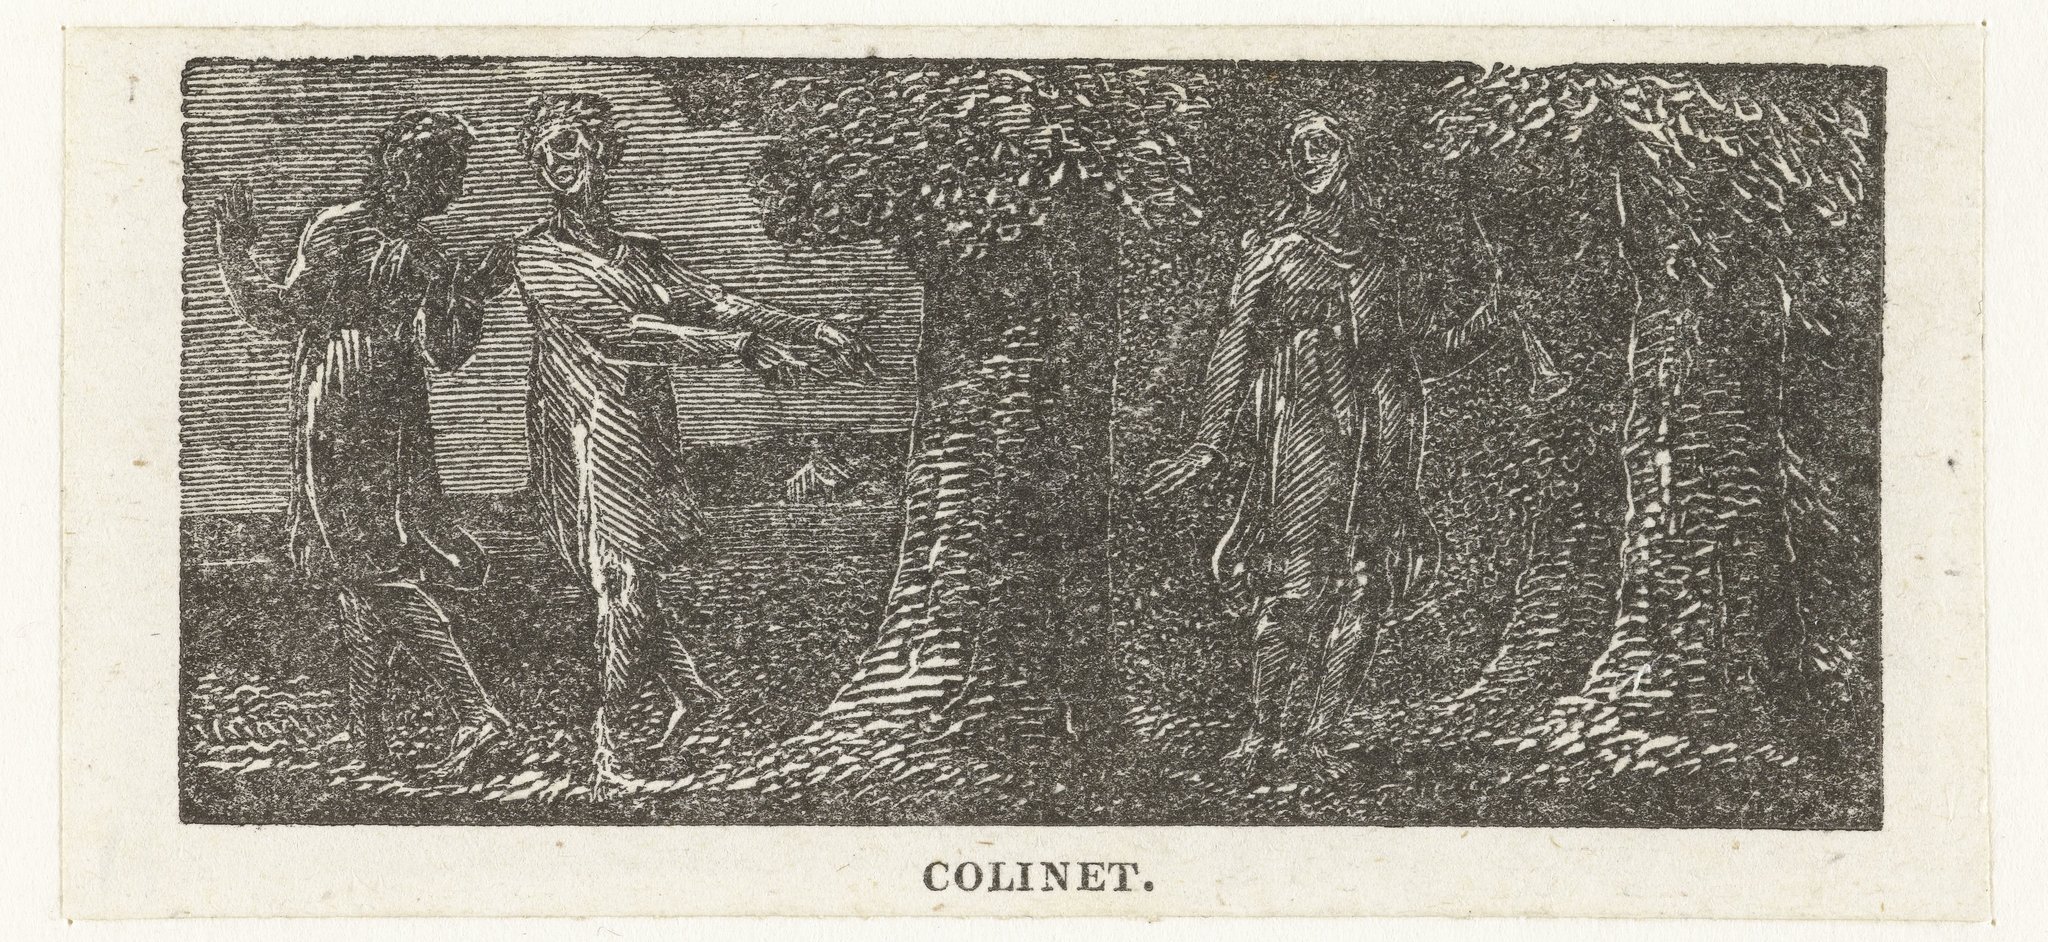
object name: print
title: Colinet mocked by two boys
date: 1820-1821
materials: paper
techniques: engraving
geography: england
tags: mocking, insulting; teasing, illustration ~ printed matter, book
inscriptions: collector's mark: Lugt 2228, inscription: ‘Colinet’, collector's mark: Lugt 2760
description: Illustratie uit "Imitations of Ecologue I", de achttiende-eeuwse imitatie van de eerste Ecloge van Vergilius, geschreven door Ambrose Philips, waarin twee herders Thenot and Colinet met elkaar converseren. De prent maakt deel uit van een serie houtgravures die als illustratie was bedoeld voor het schoolboek "The Pastorals of Virgil", uitgegeven in 1821. De opdracht voor deze prenten is gegeven door Dr R.J. Thornton. Botke, K.